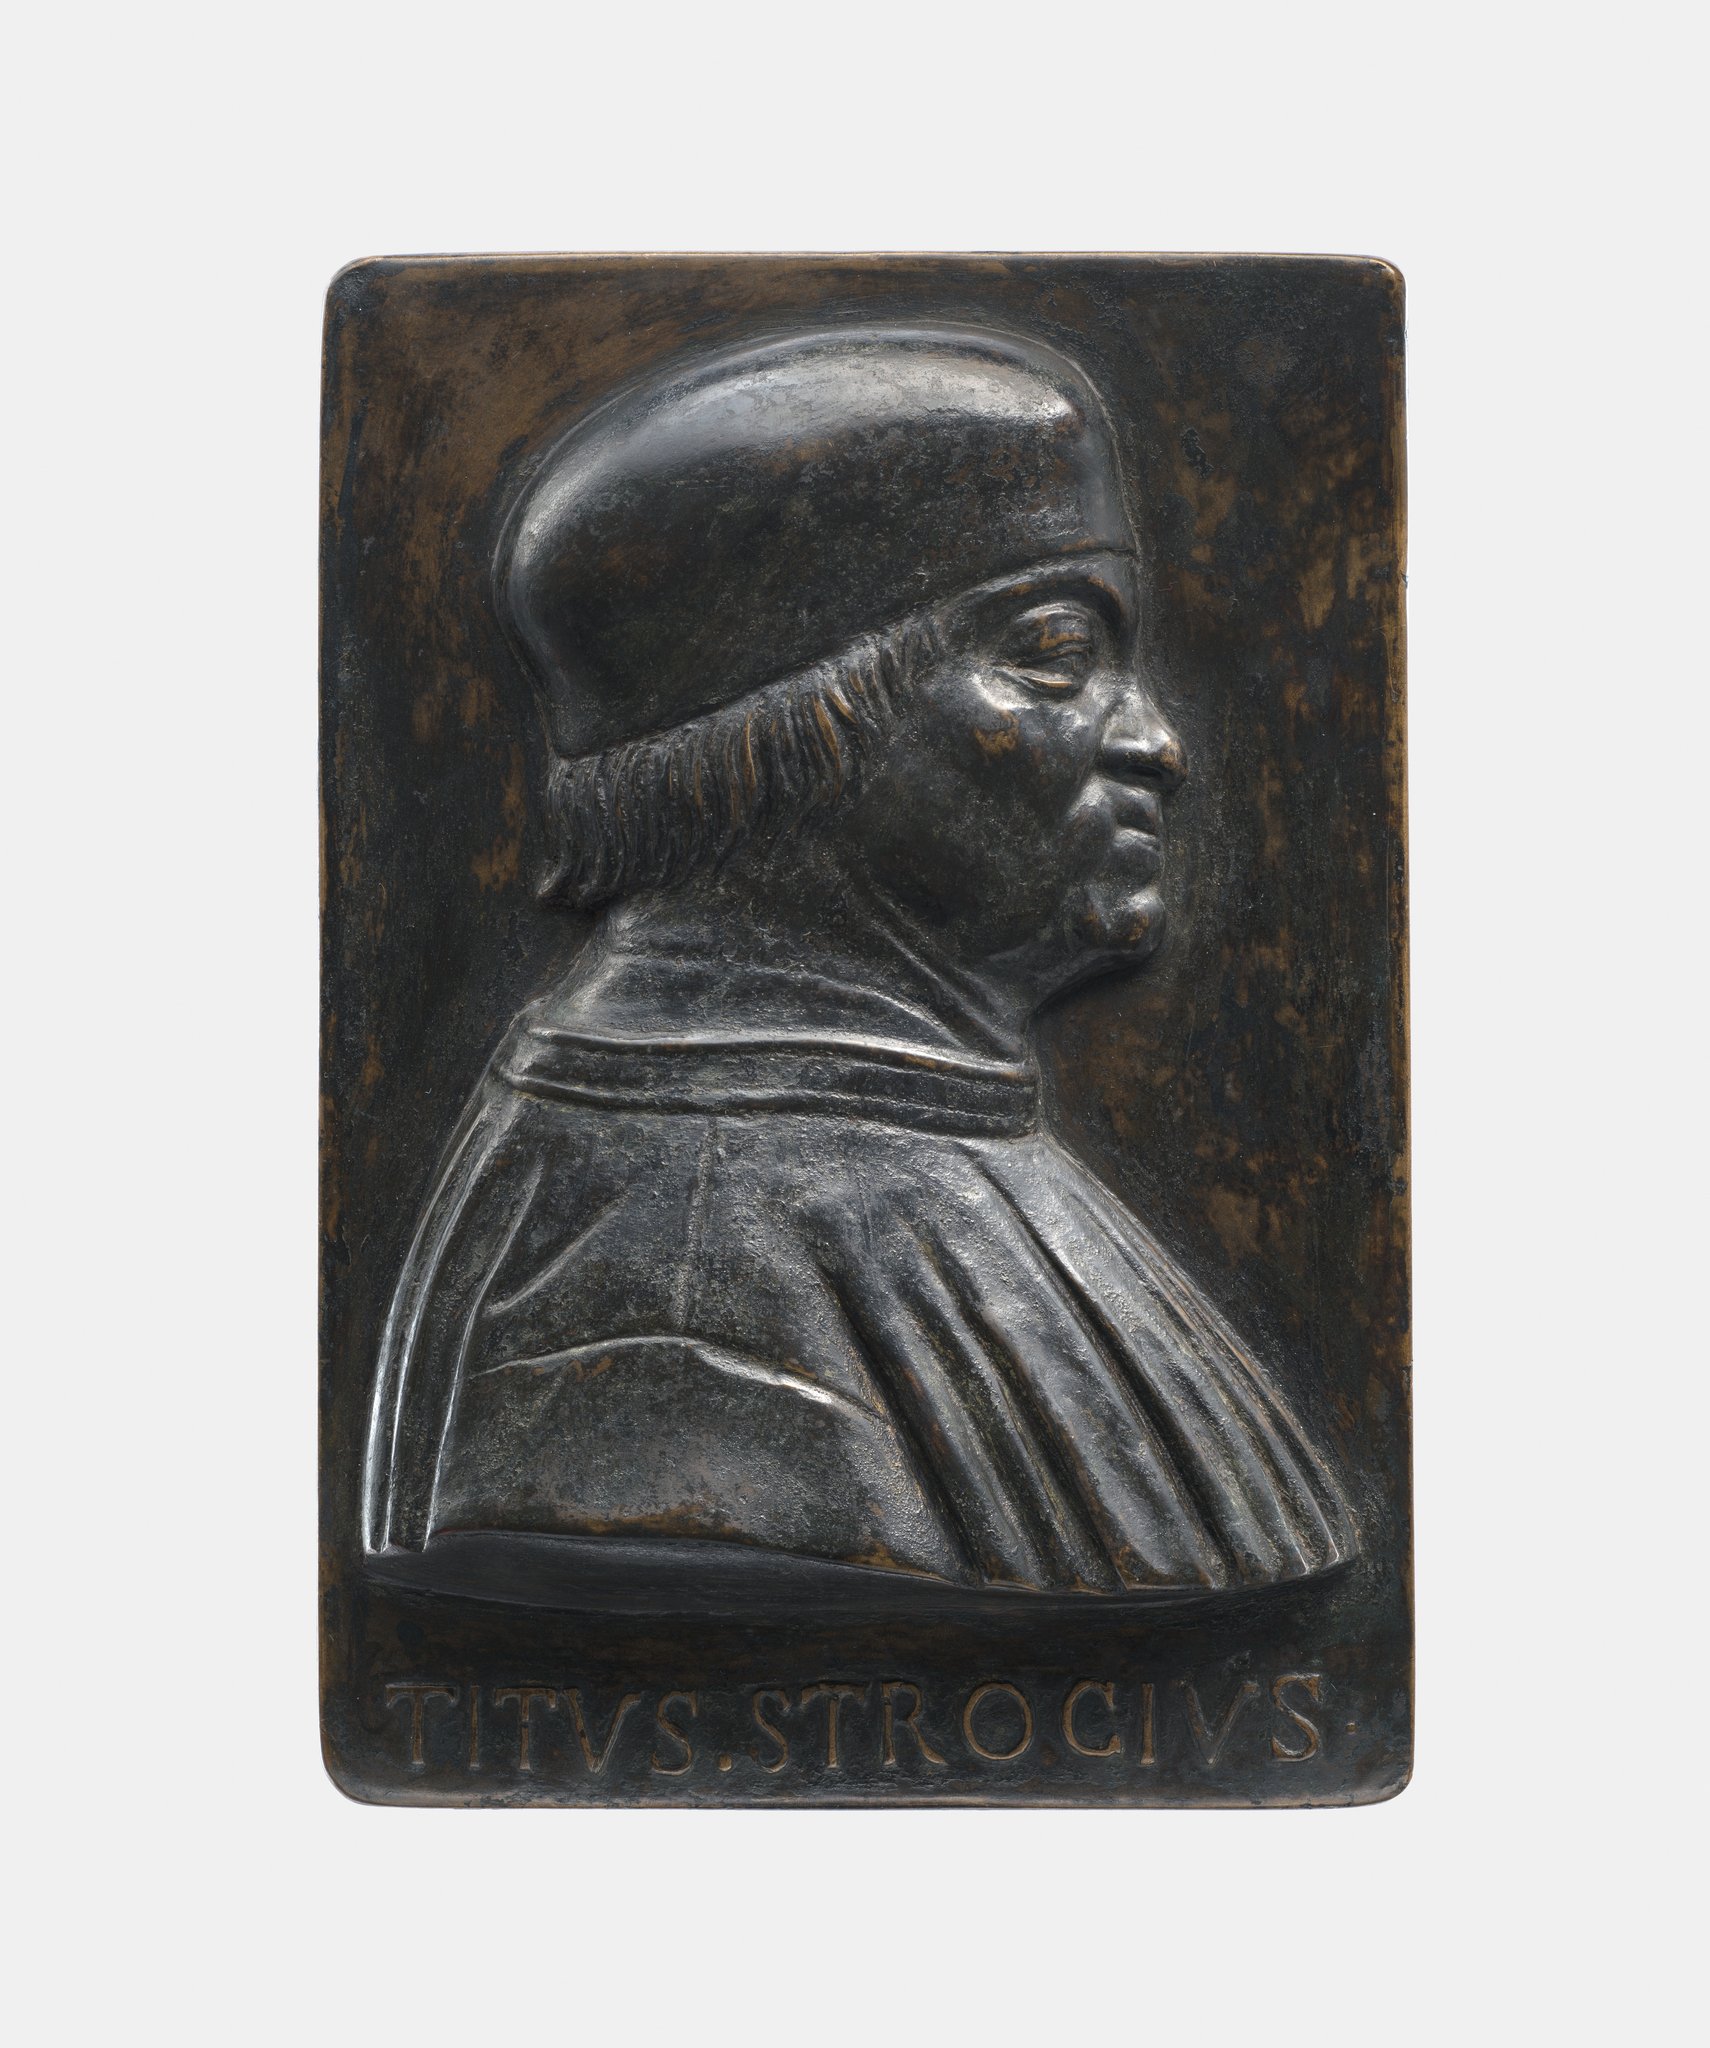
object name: medal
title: Tito Vespasiano Strozzi 1422–1505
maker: Anonymous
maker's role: artist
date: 1500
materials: bronze